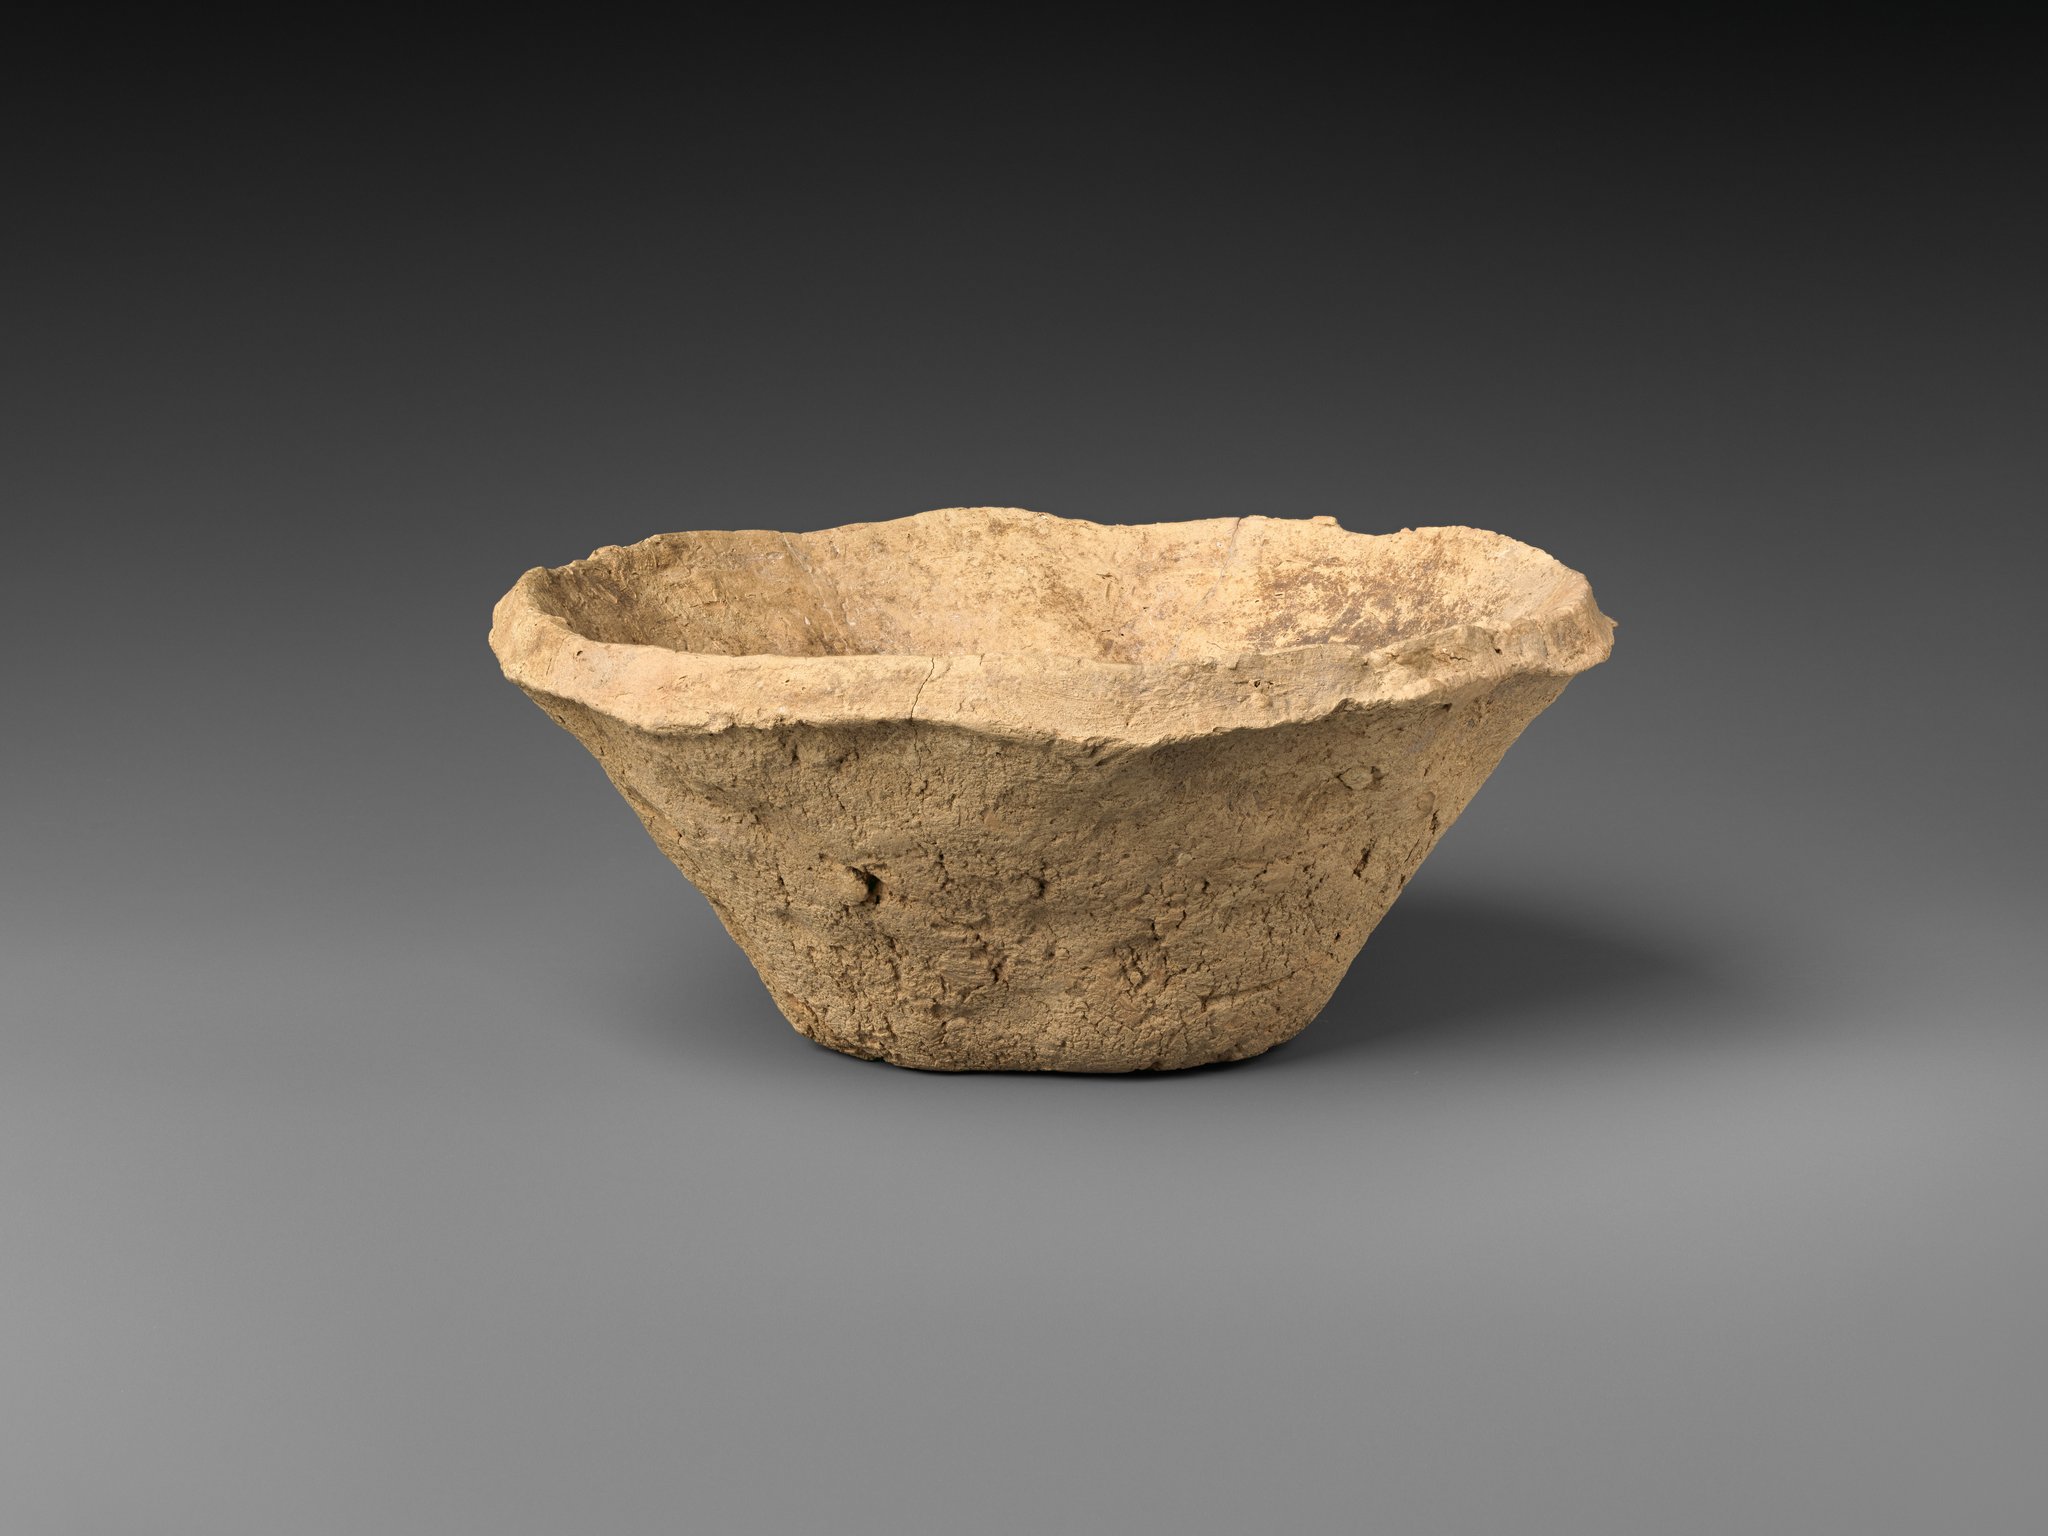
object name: bowl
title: Beveled rim bowl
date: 3300-3100 BCE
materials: ceramic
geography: mesopotamia